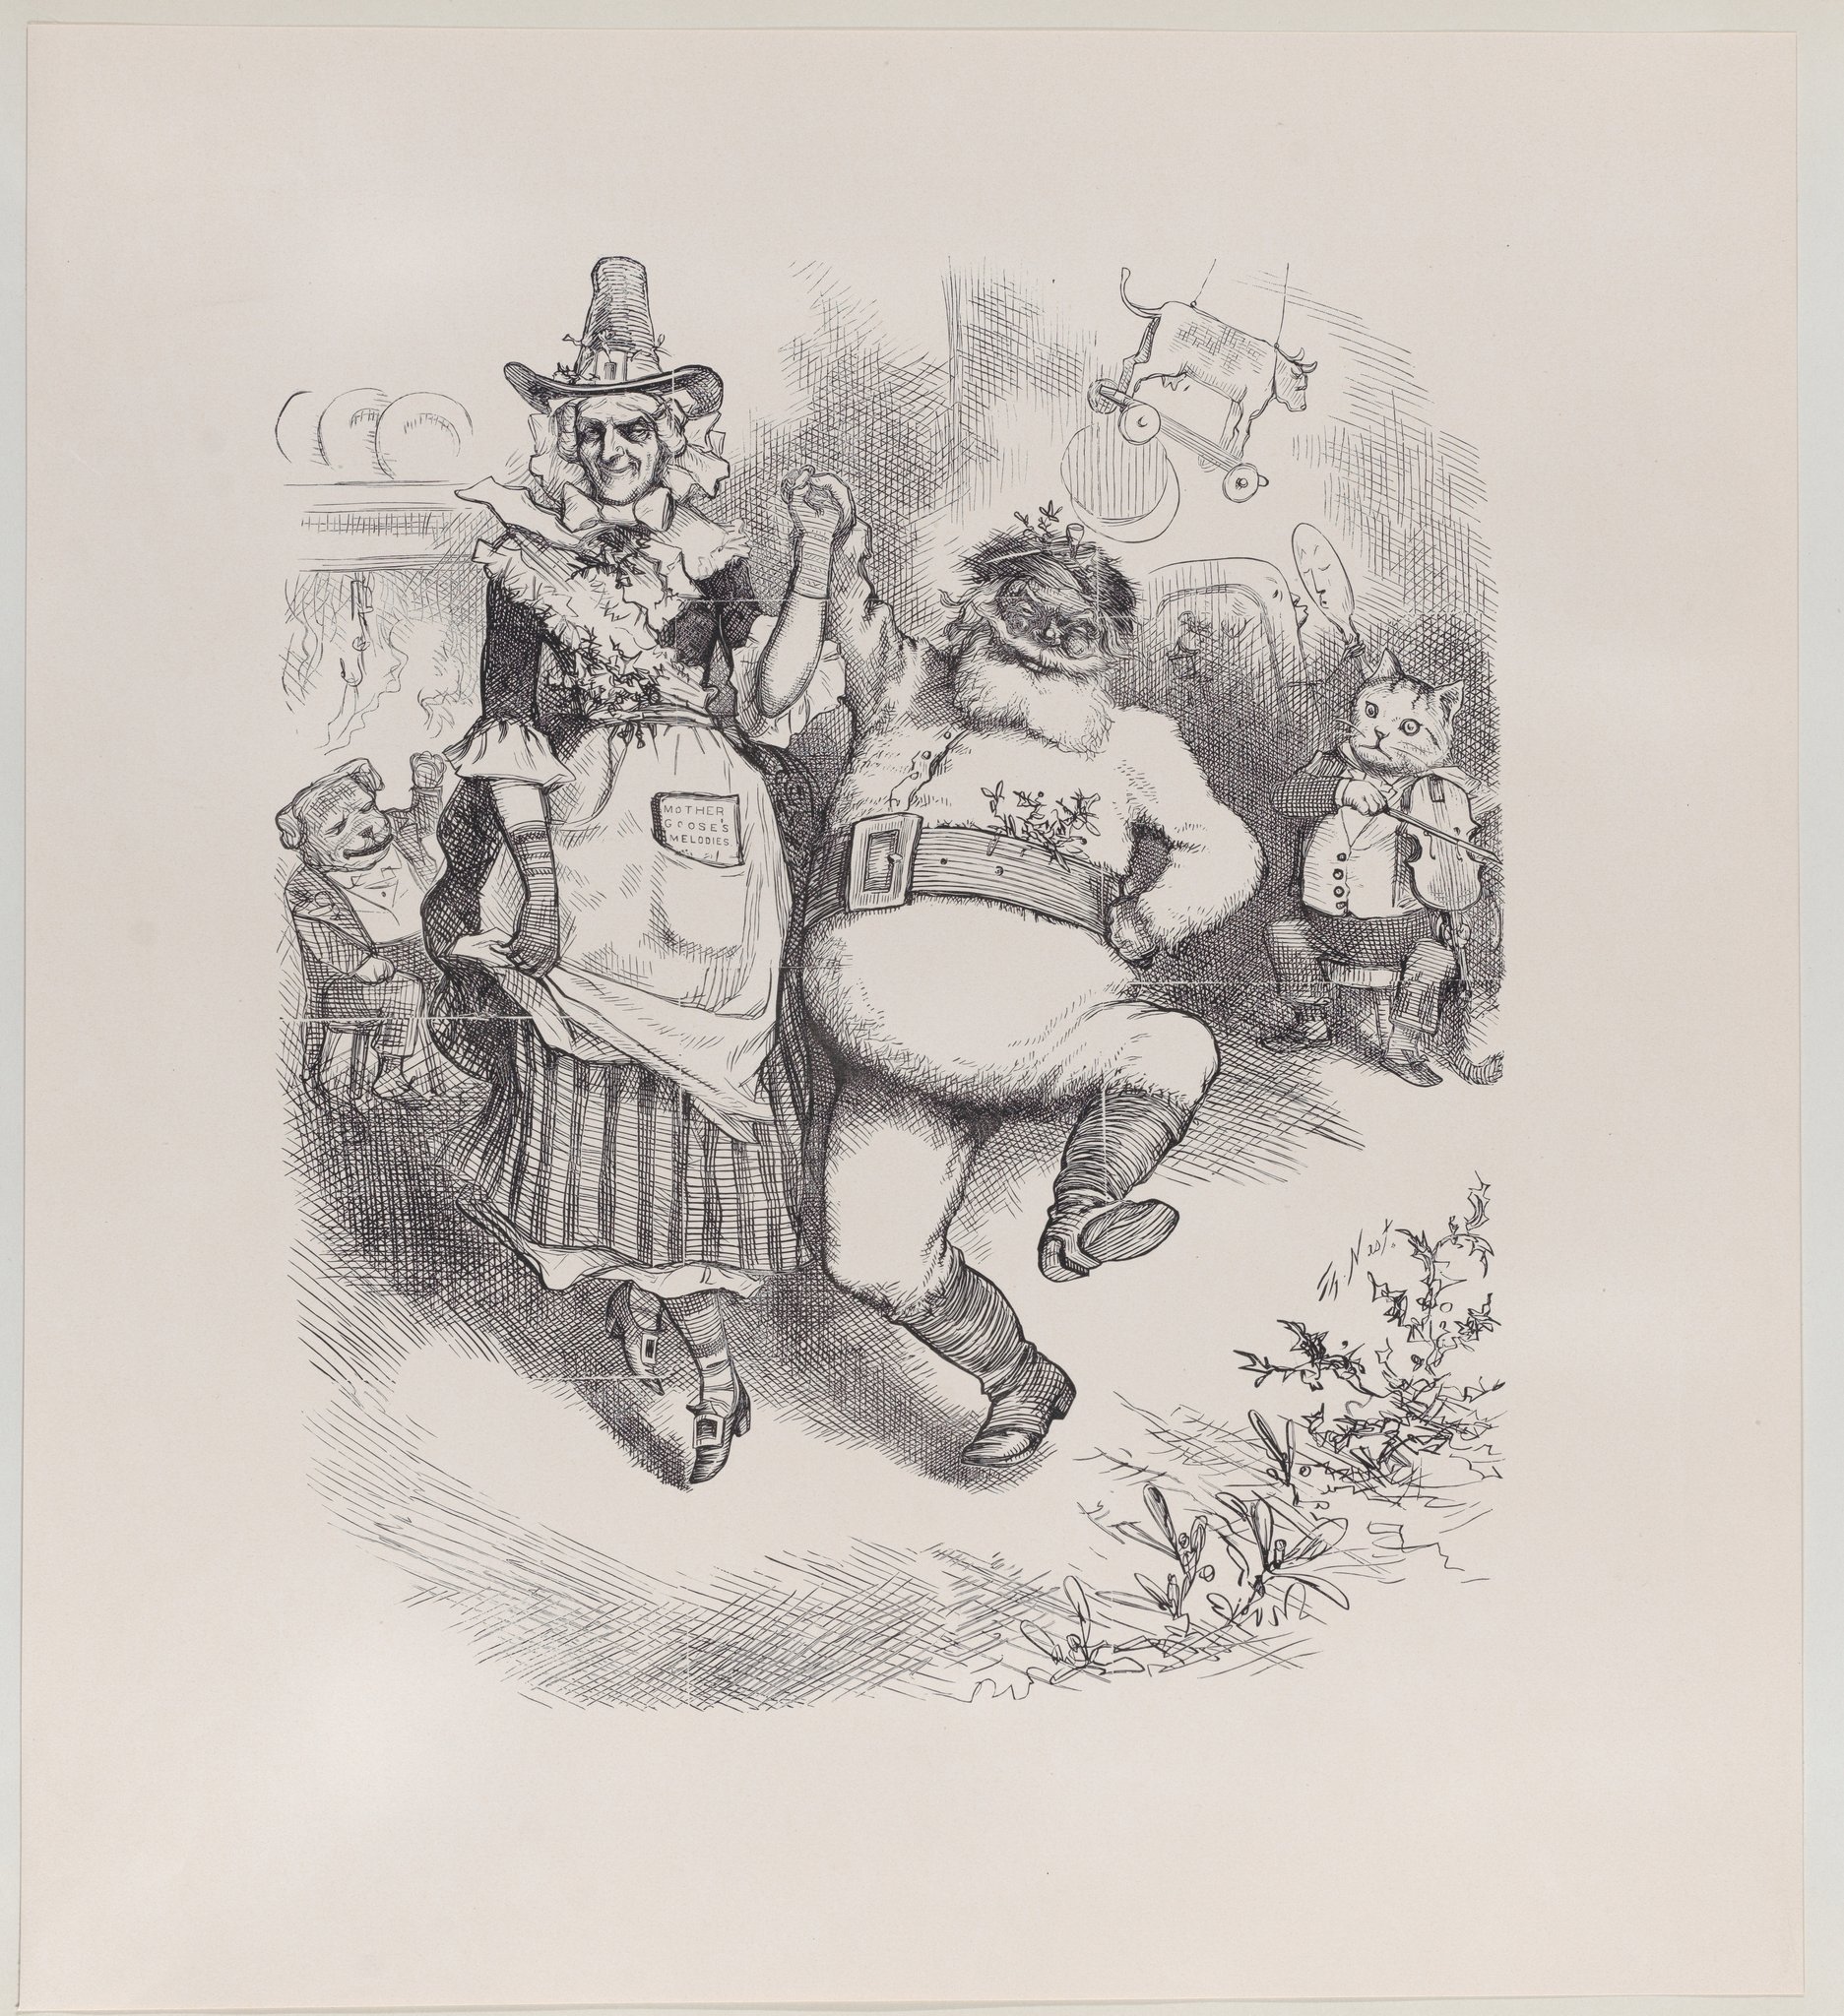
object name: print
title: A Merry Christmas (published in "Harper's Weekly," January 3, 1880)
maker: thomas nast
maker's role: artist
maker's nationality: american, born germany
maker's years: 1840-1902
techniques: relief print